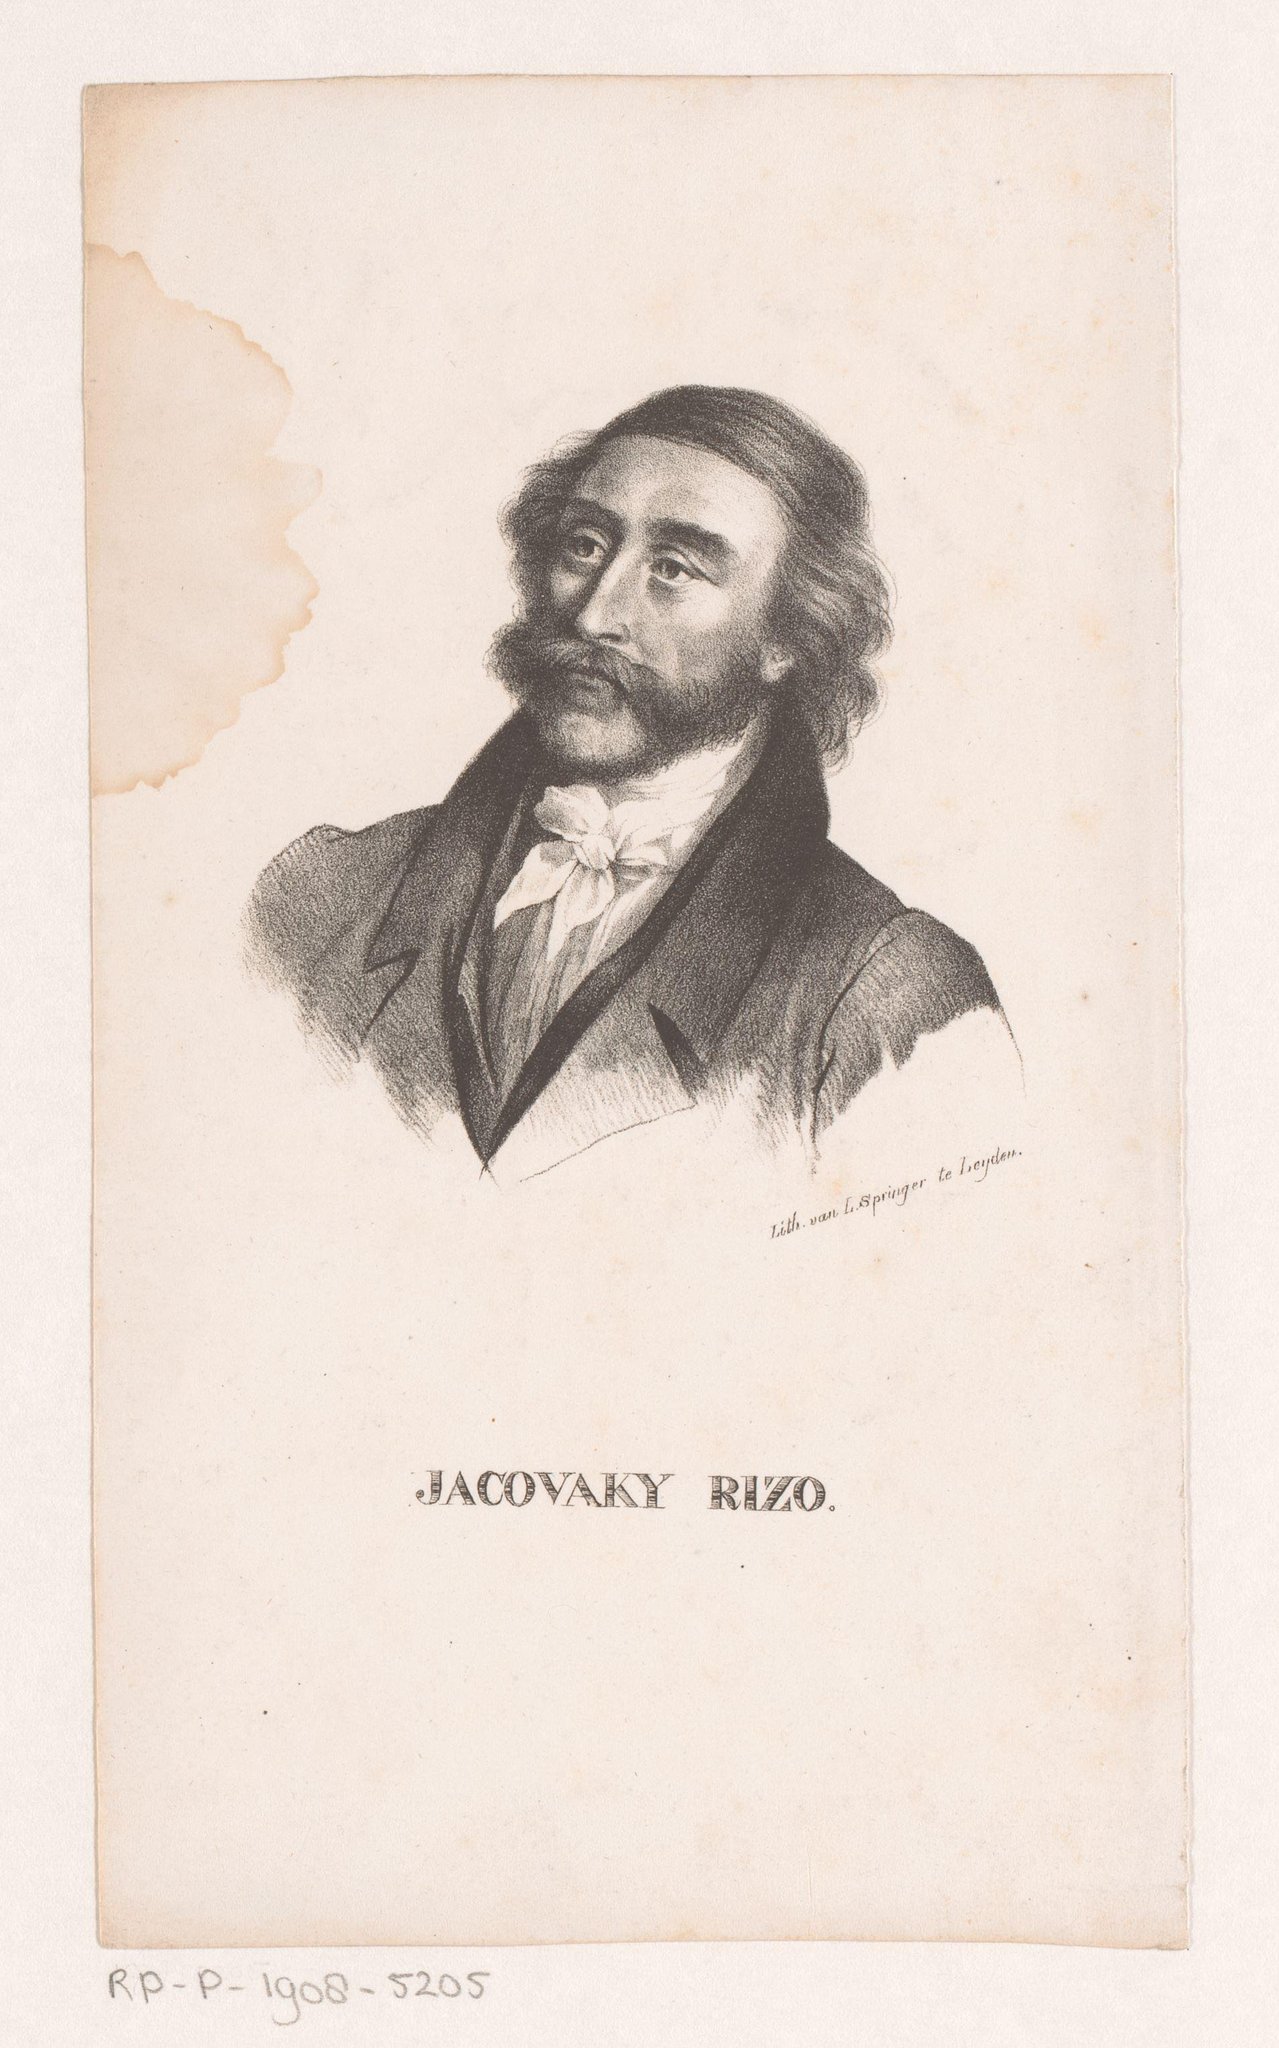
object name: print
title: Jacovaky Rizo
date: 1809-1871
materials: paper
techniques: lithograph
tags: historical persons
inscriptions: collector's mark: Lugt 2228